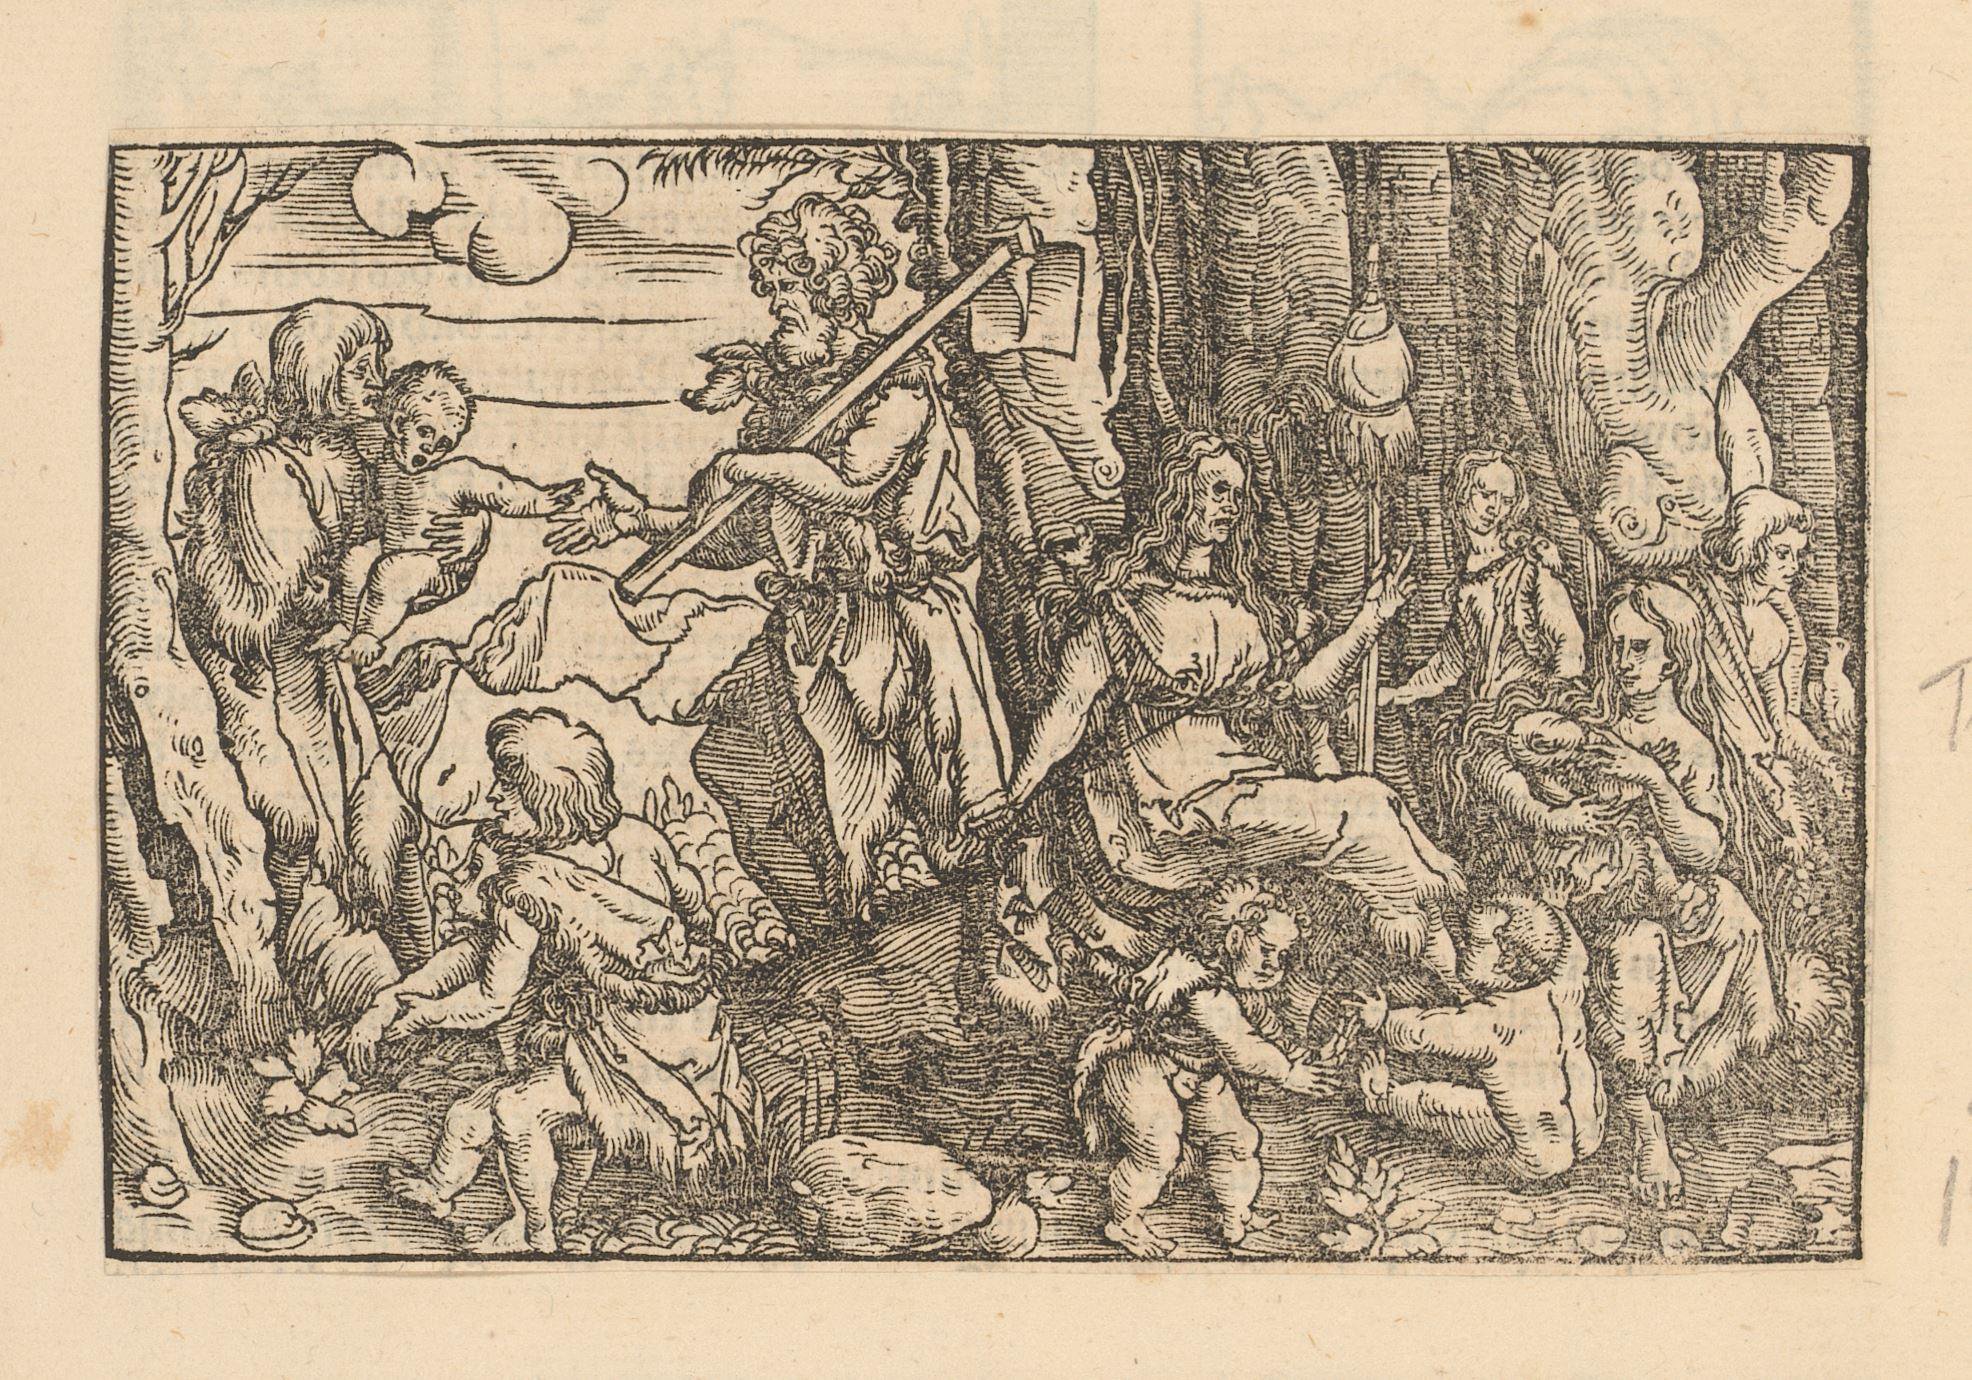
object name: album leaf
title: Grote familie in een bos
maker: Anonymous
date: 1514-1532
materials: paper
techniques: letterpress printing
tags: clothed in rags, distaff, hand shovel-board, family life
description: Deze prent is gebruikt in: Petrarca, Francesco. Von der Artzney bayder Glück, des guten und widerwertigen: unnd weß sich ain yeder inn Gelück und Unglück halten sol (...). Augsburg: Heinrich Steiner, 1532. Deze uitgave is ook bekend onder de titel 'Trostspiegel in Glück und Unglück'.